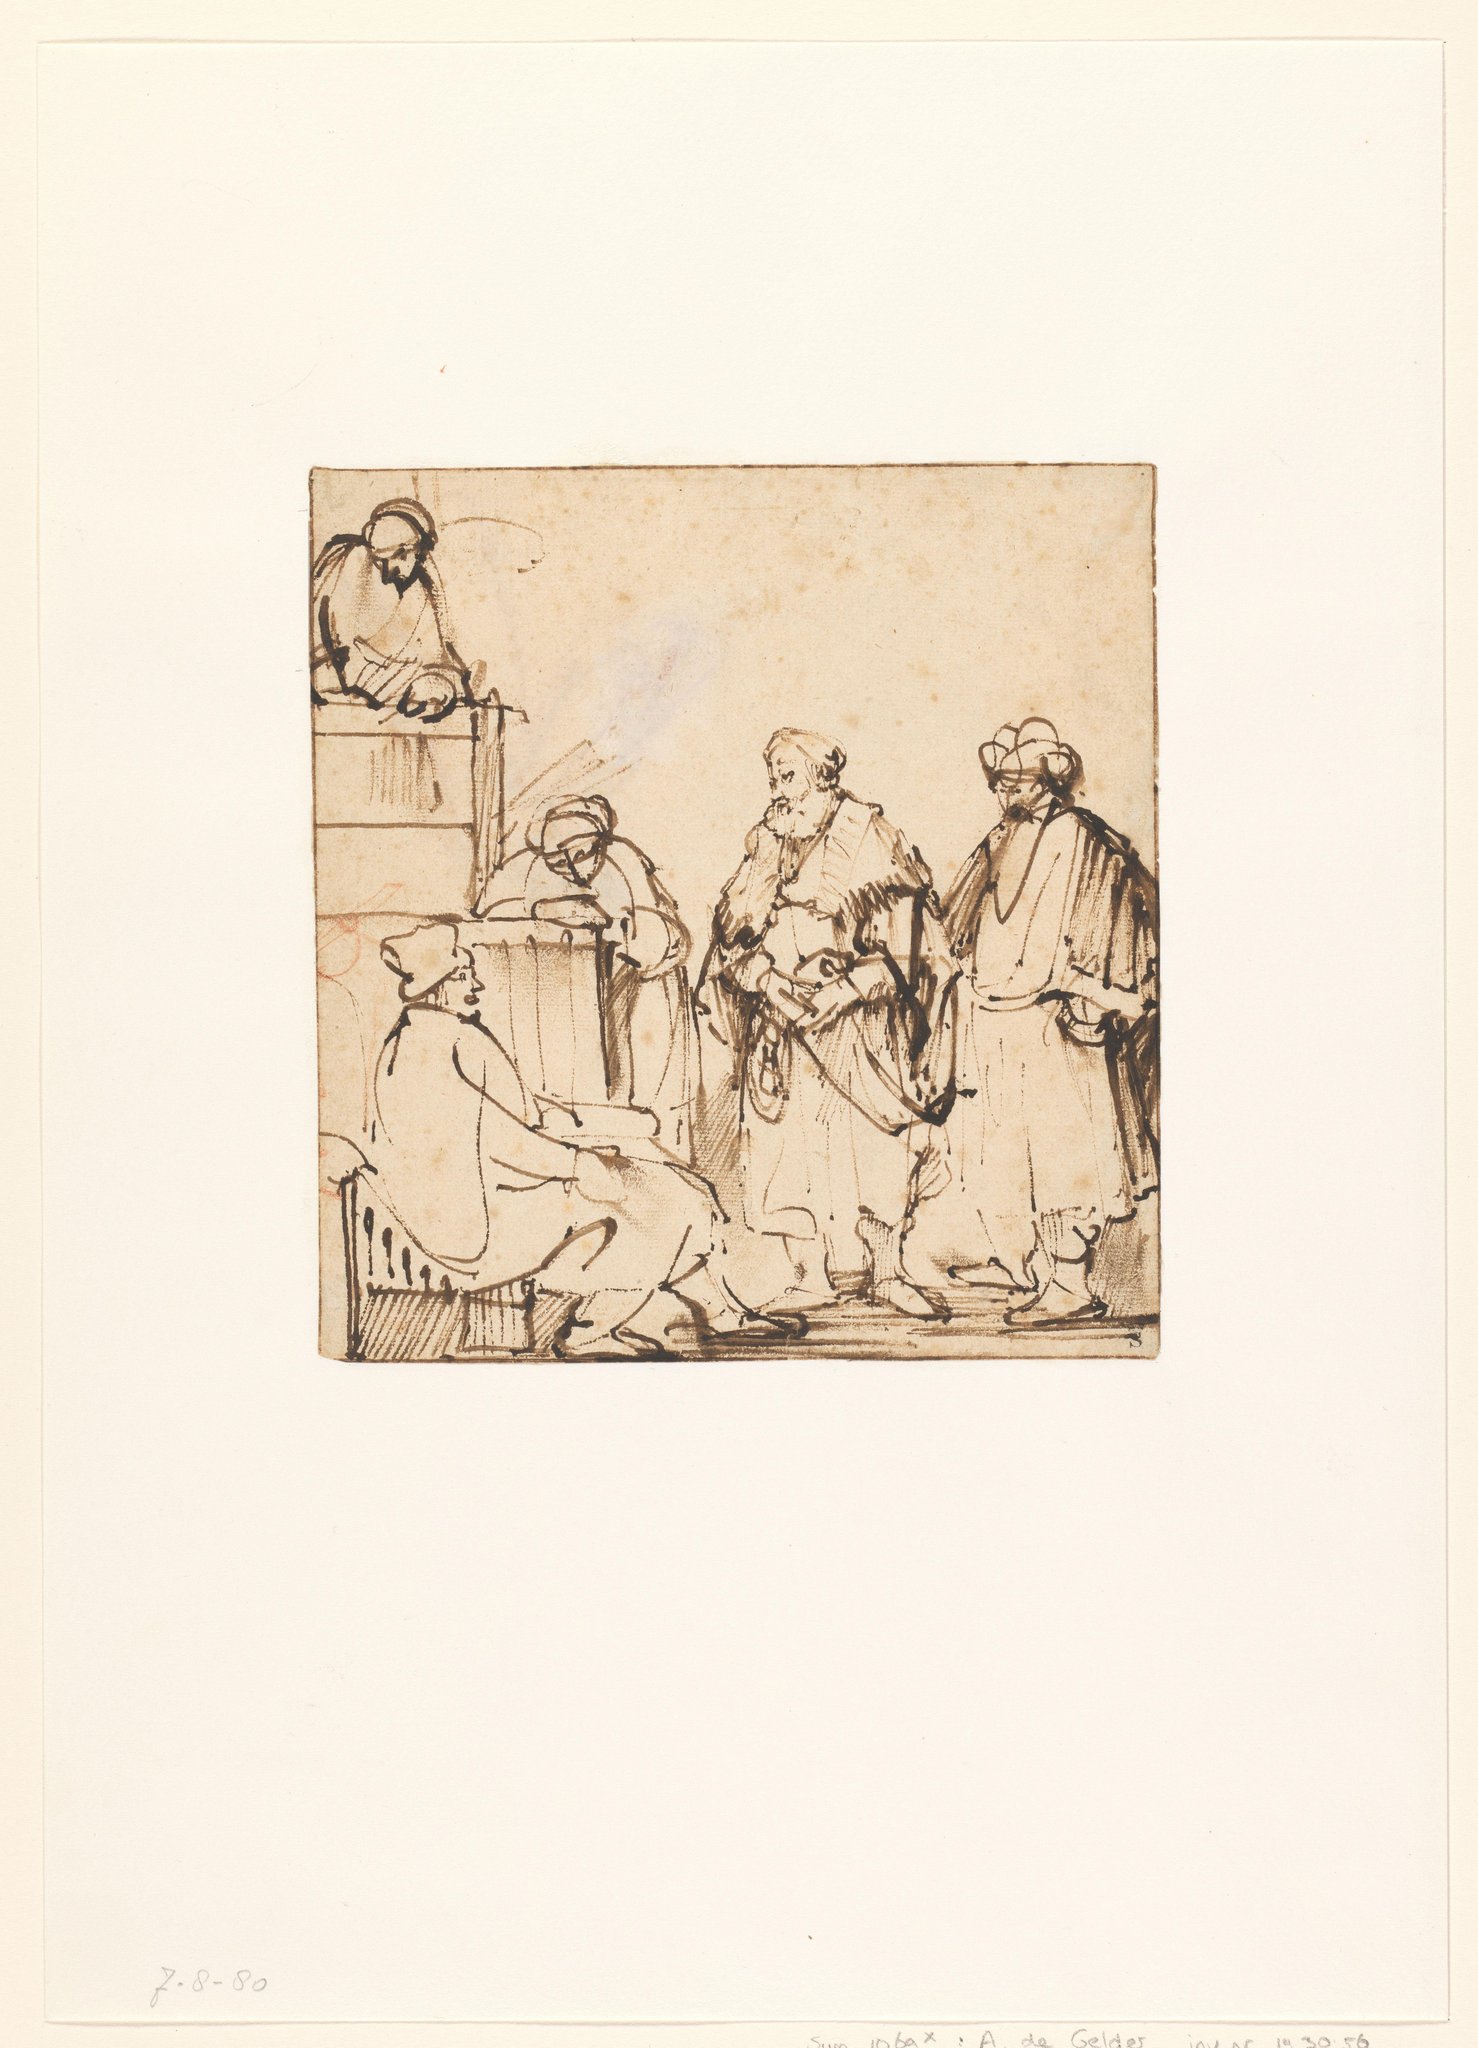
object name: drawing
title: Job and his Friends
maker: aert de gelder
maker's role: draughtsman, painter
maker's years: 1645-1727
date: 1640-1690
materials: chalk, ink, paper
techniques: pen